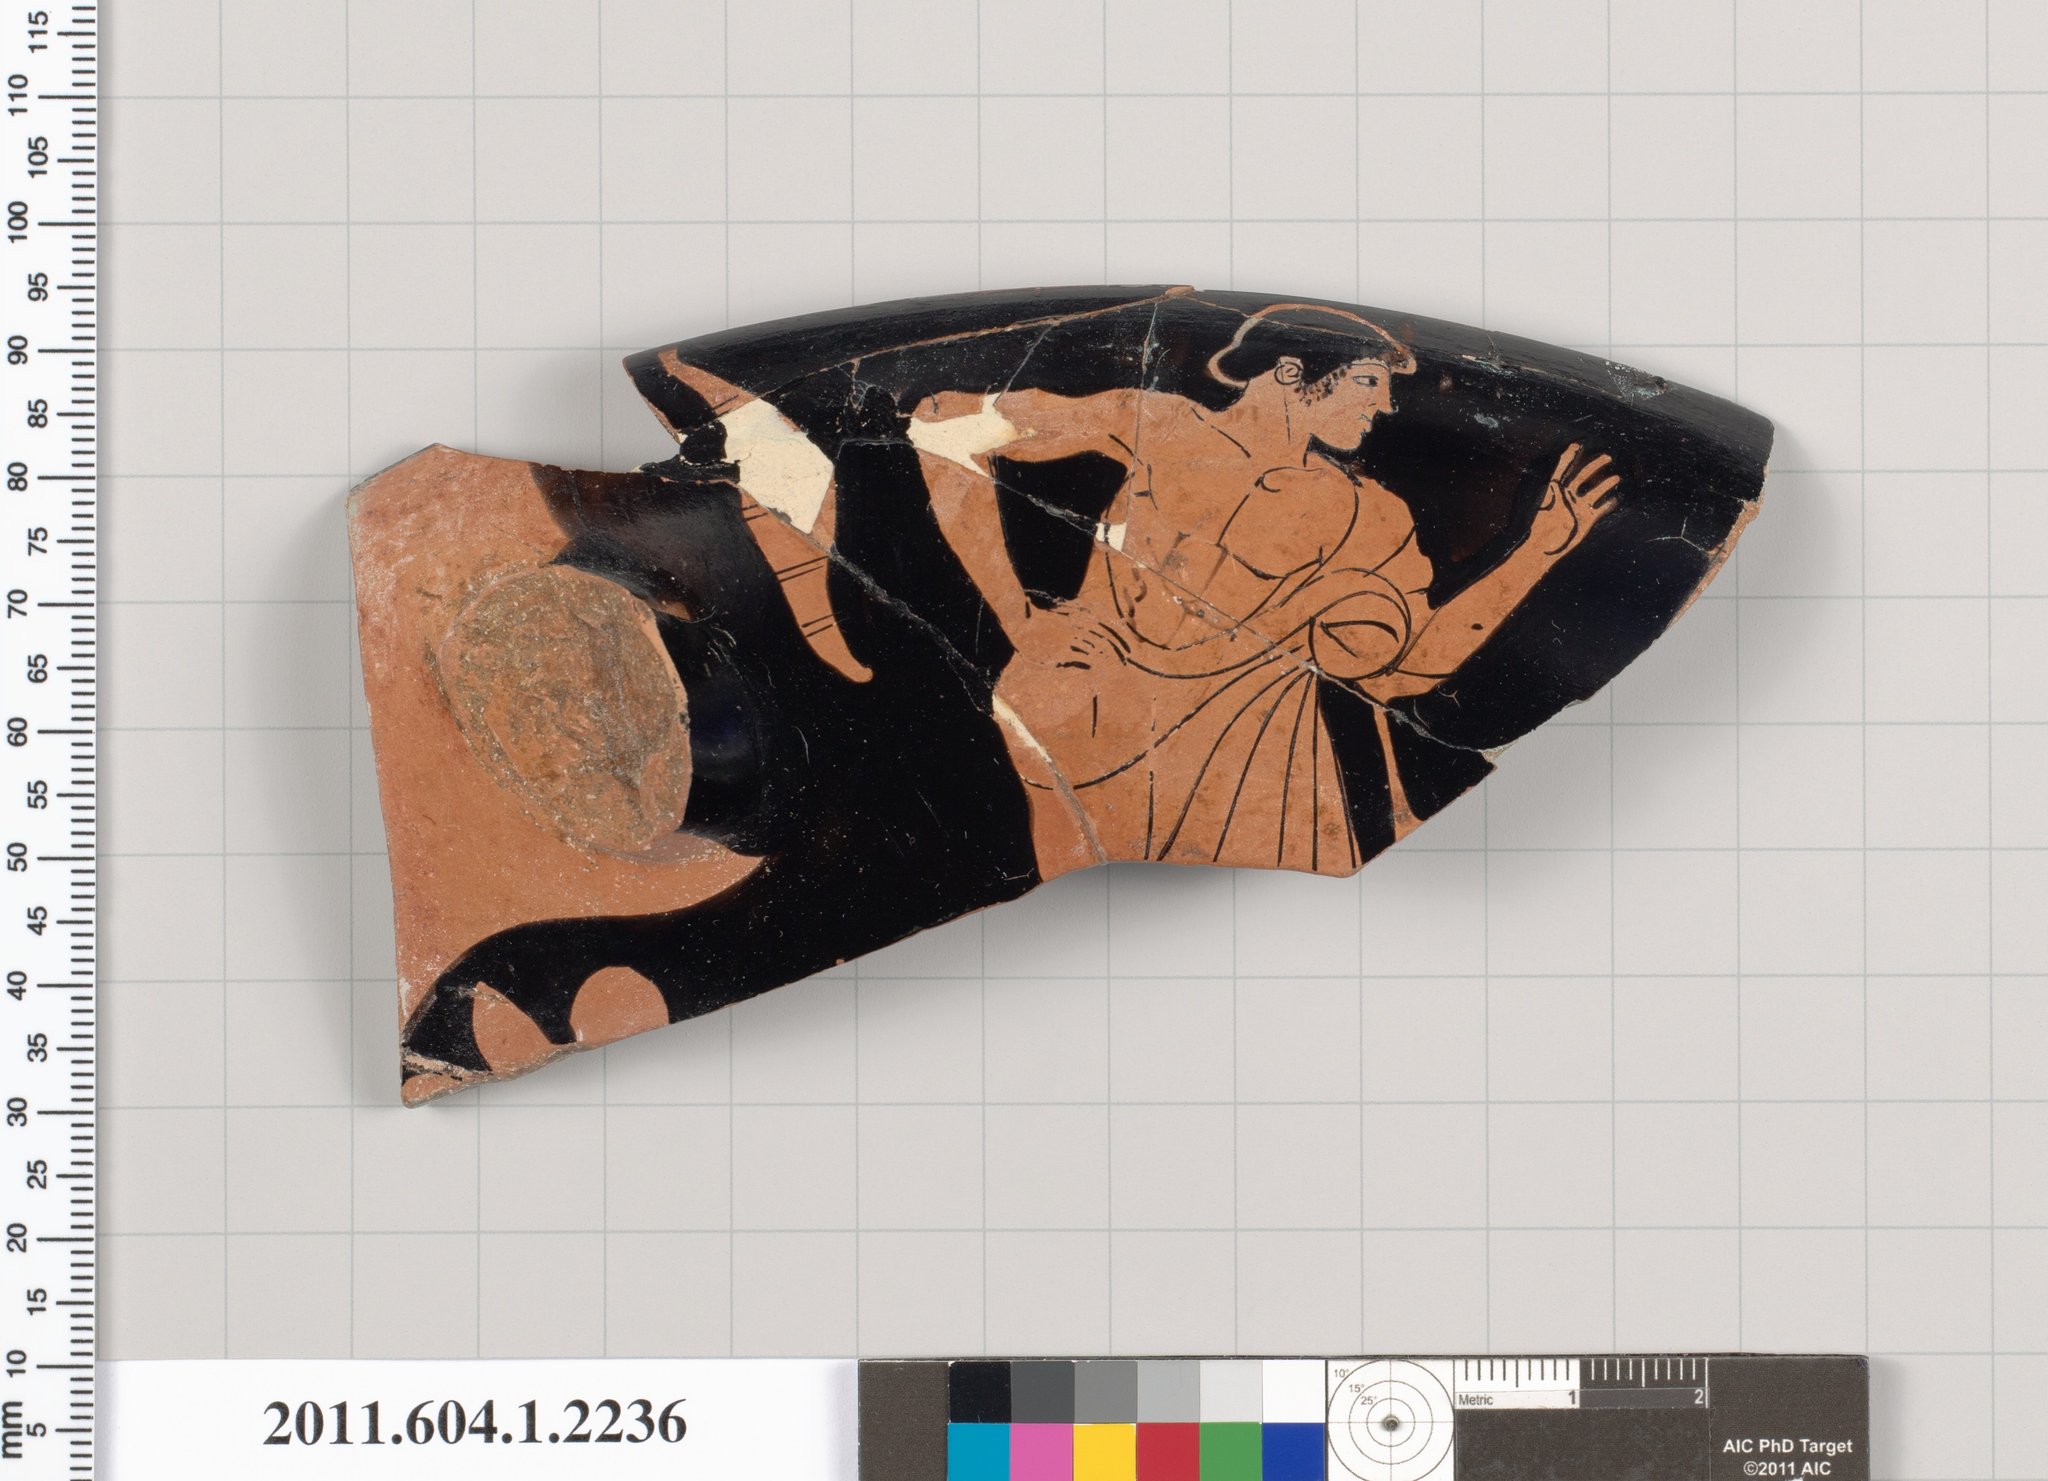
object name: kylix fragment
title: Terracotta rim fragment of a kylix (drinking cup)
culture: greek, attic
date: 490-480 BCE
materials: terracotta